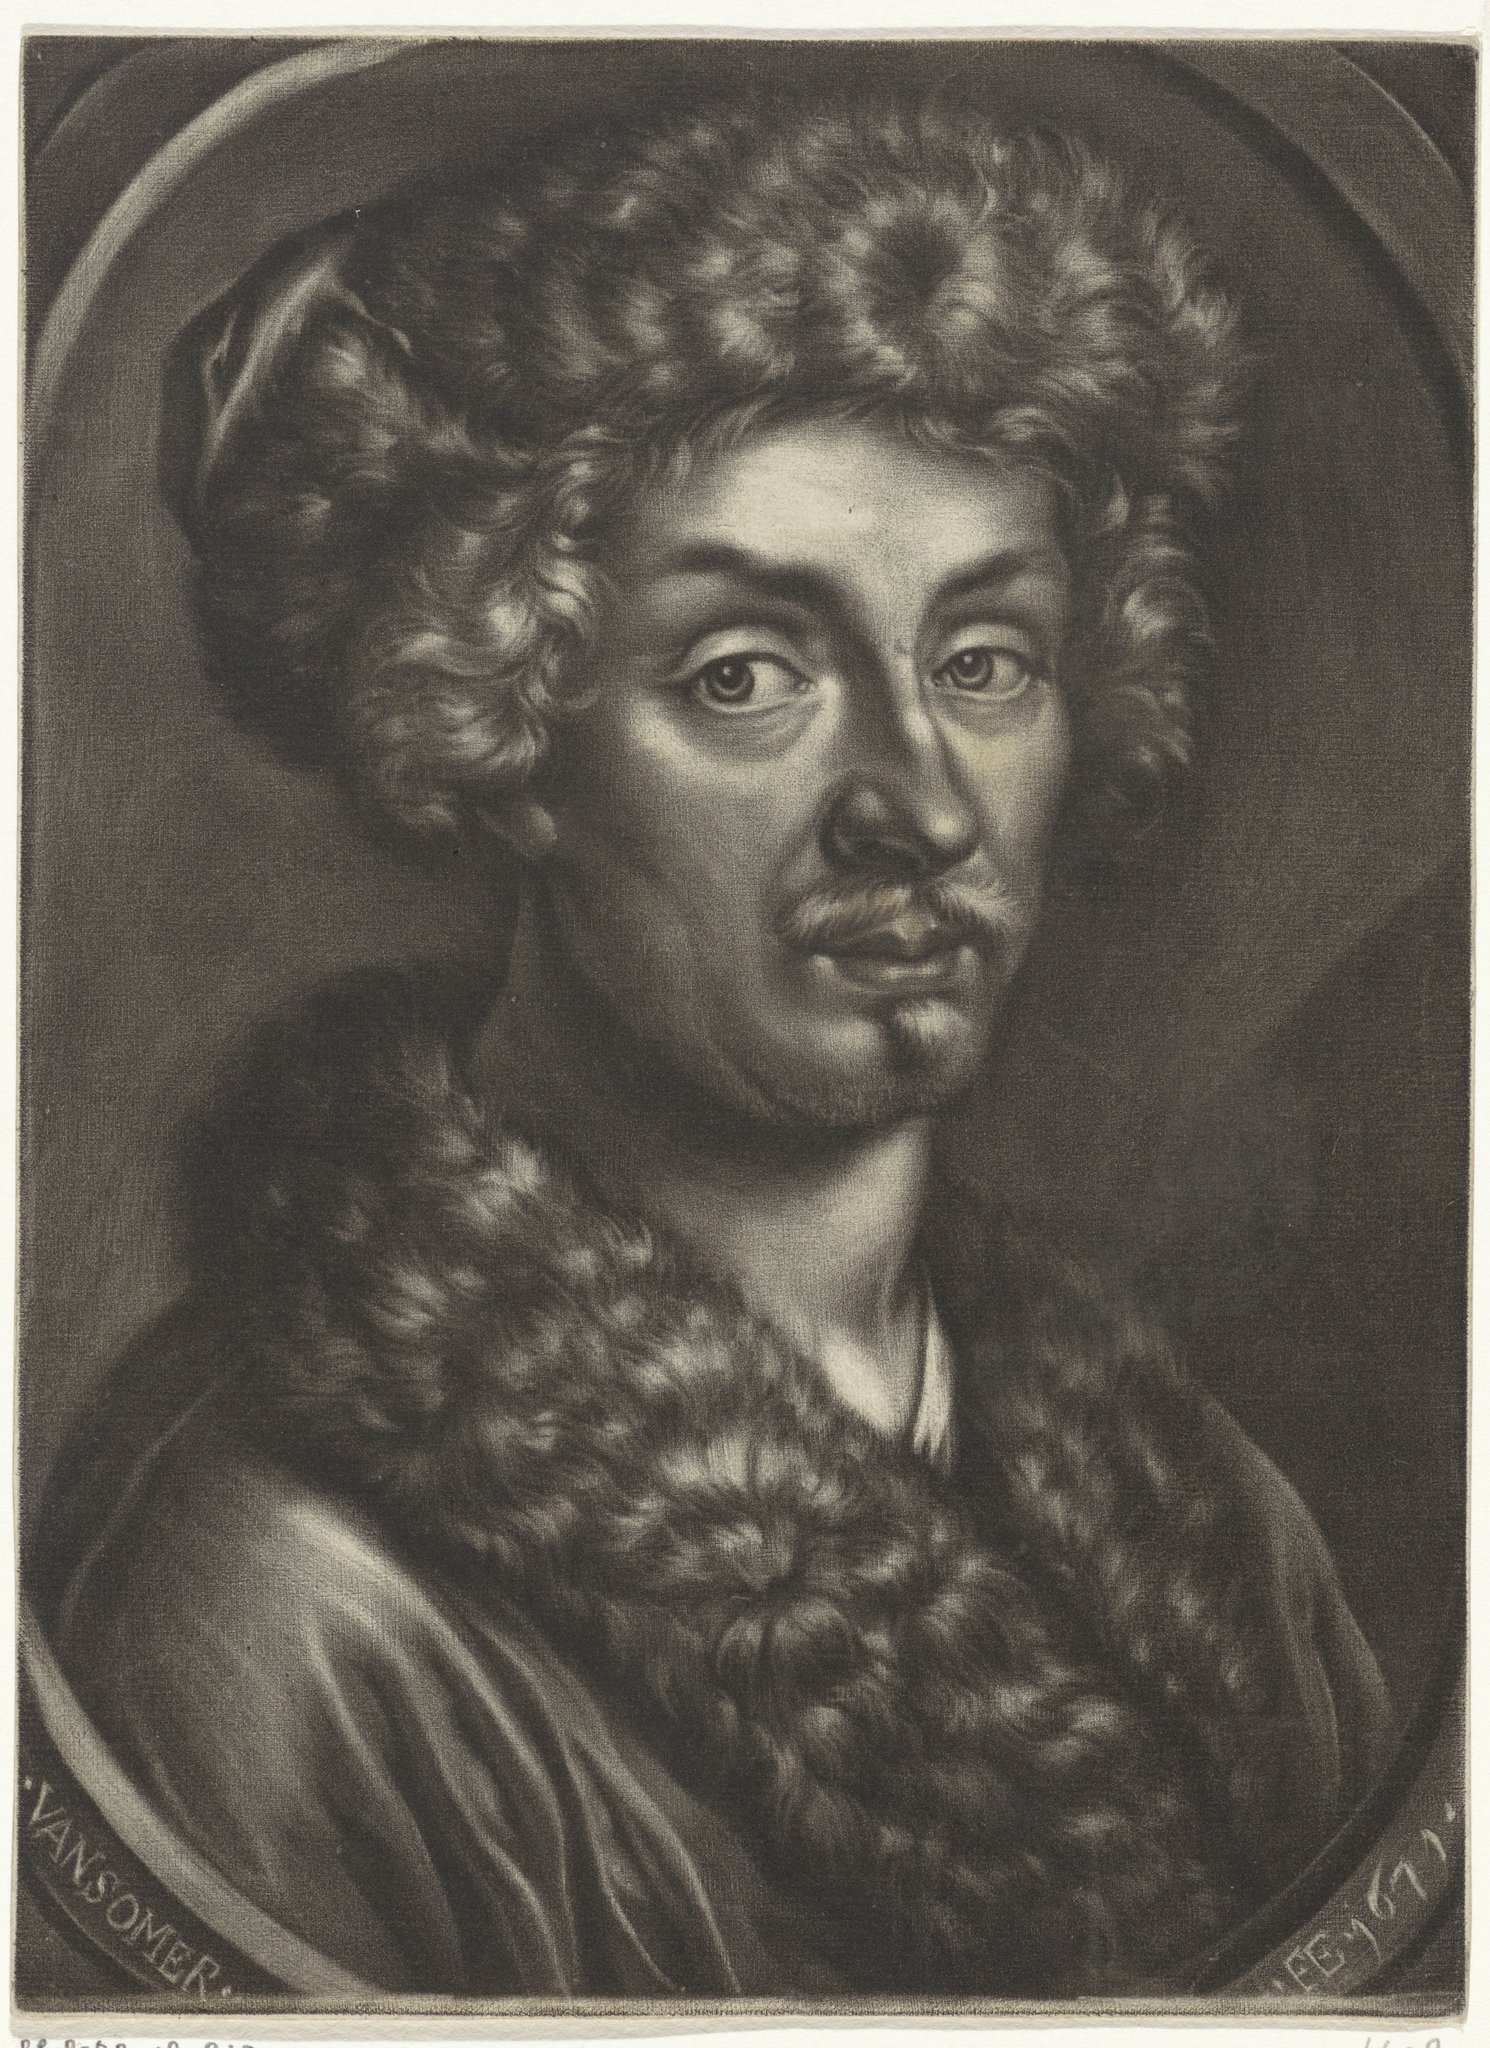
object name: print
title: Portret van een man met een bontmuts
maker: jan van somer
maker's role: draughtsman, print maker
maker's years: 1645-1699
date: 1671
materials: paper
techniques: mezzotint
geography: amsterdam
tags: head-gear (with name)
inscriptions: collector's mark: Lugt 2228